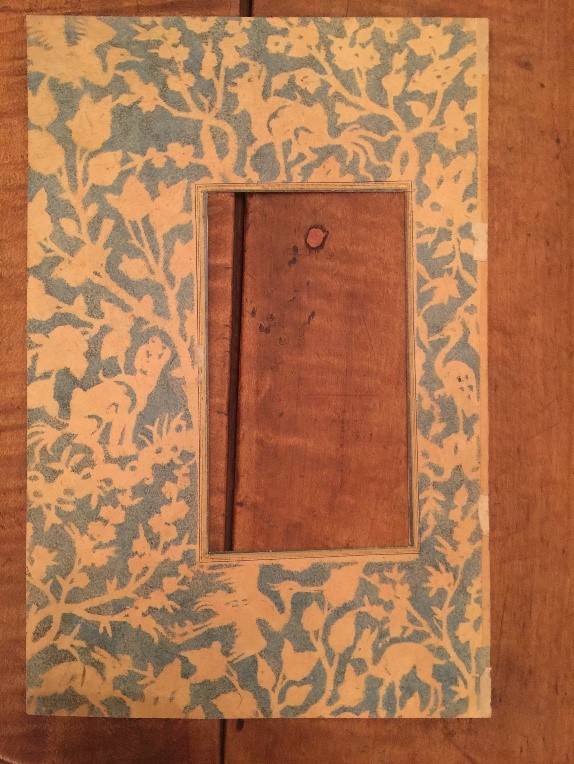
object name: folio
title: Stenciled Folio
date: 1501-1800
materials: gold, paper, watercolor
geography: iran